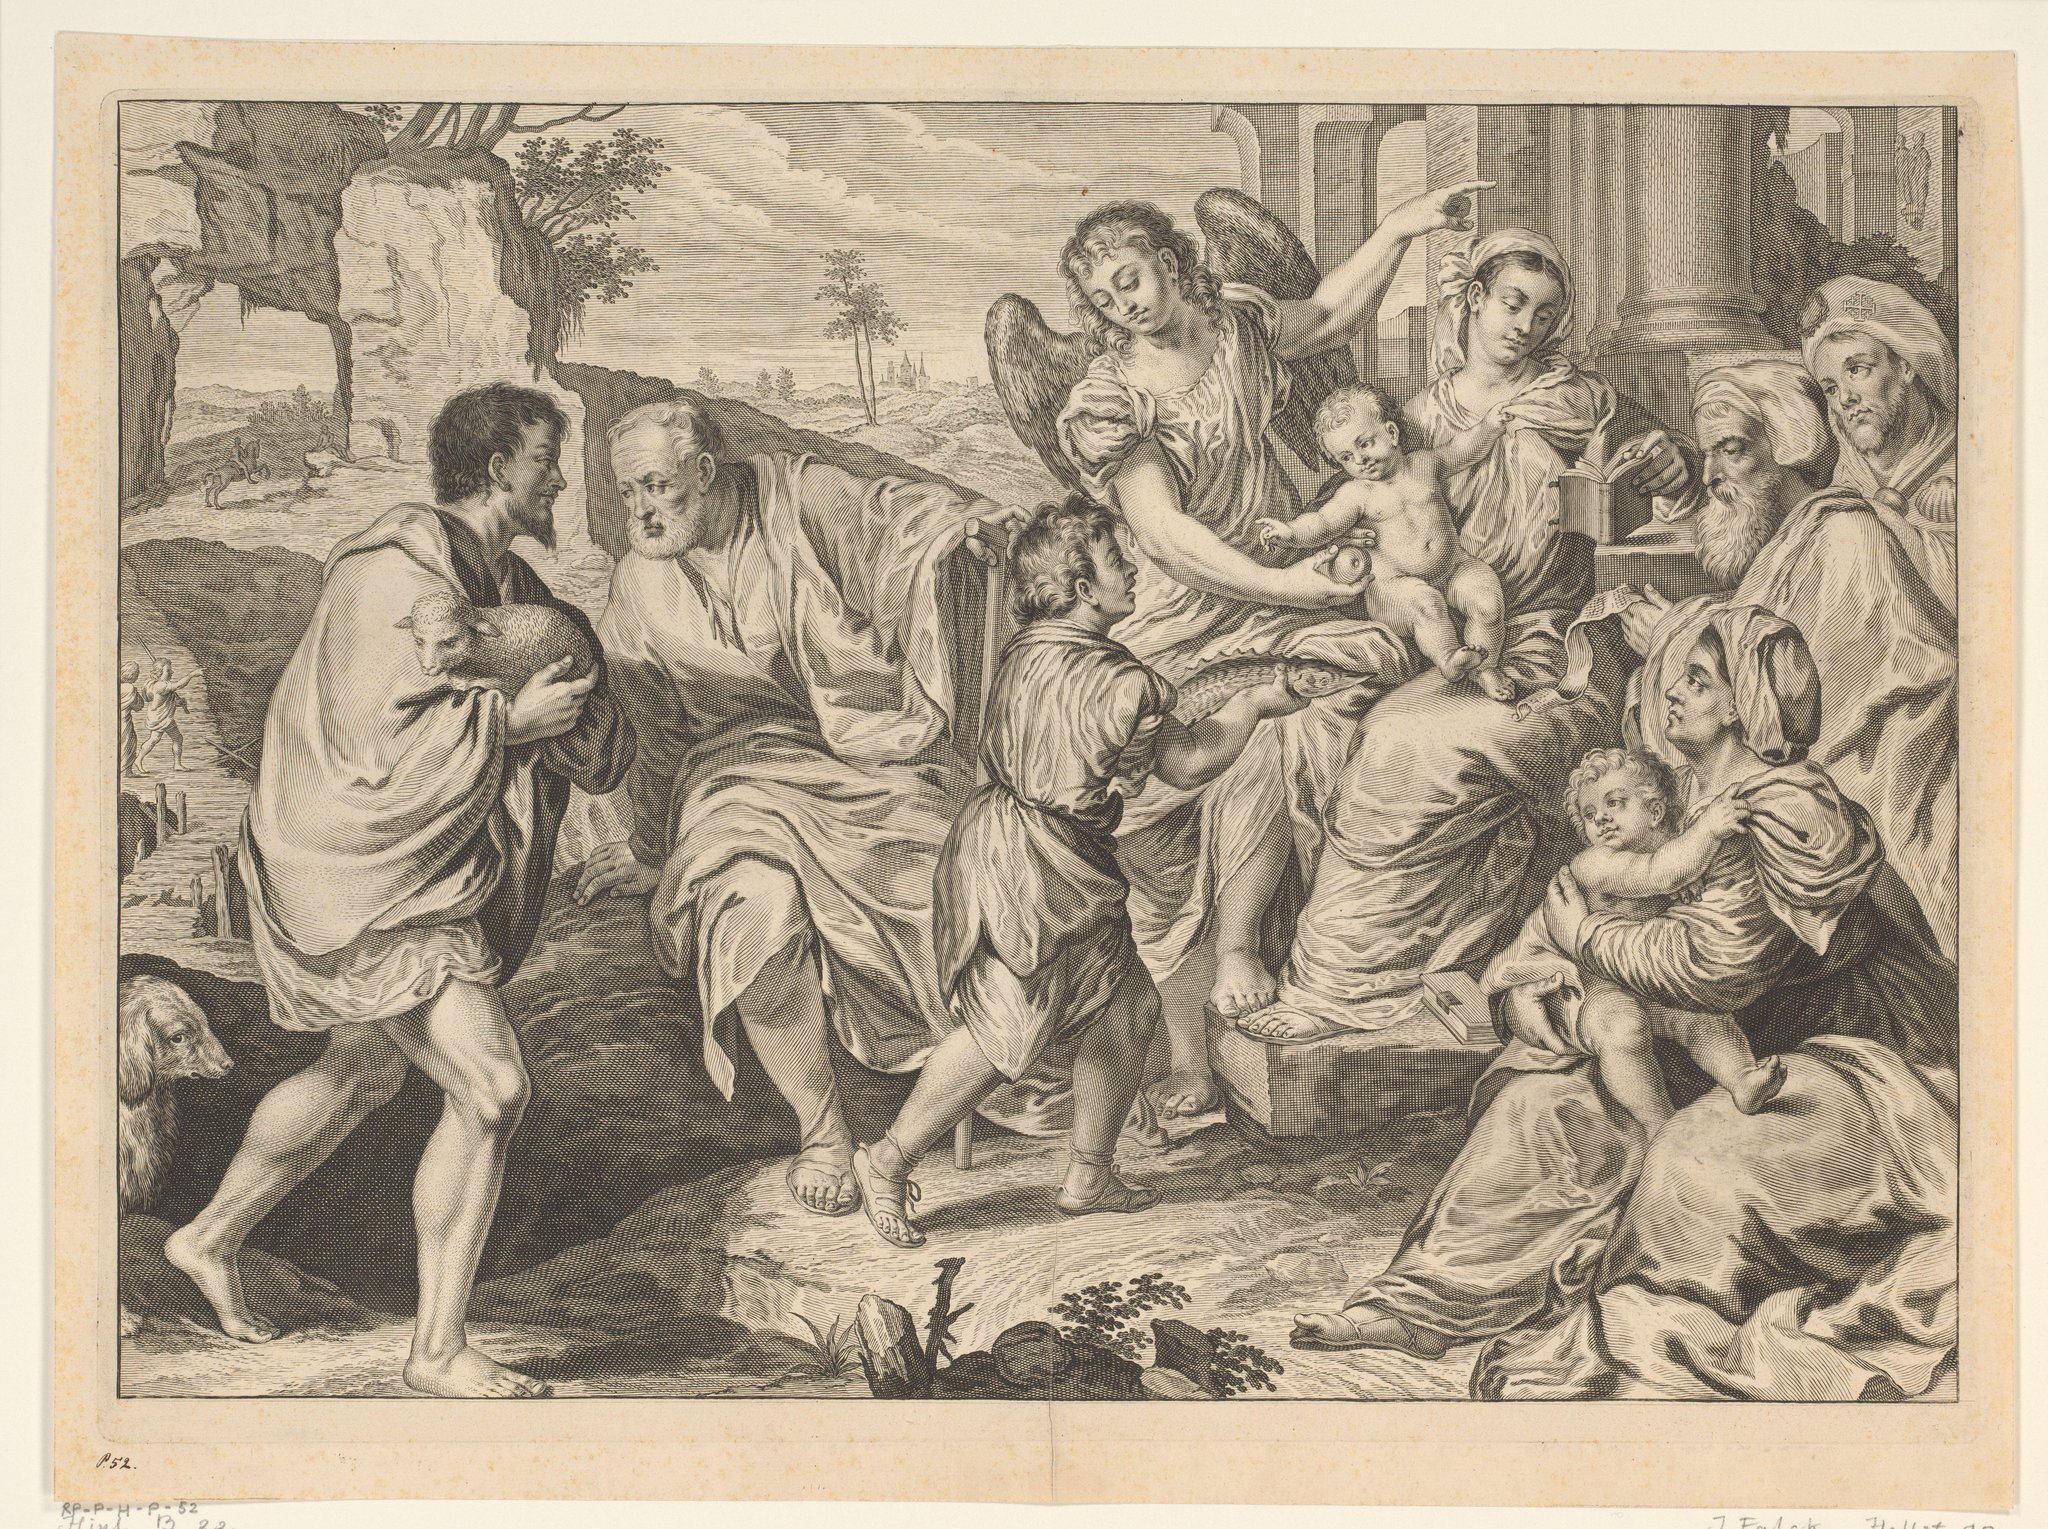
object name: print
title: Heilige familie in gezelschap van anderen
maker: jeremias falck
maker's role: print maker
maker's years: 1609-1677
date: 1646-1658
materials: paper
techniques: engraving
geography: amsterdam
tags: holy family with john the baptist (as child)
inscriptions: collector's mark: Lugt 11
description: Deze prent maakte ten minste tot 1979 deel uit van een prentalbum met de titel: 't Cabinet der Italiaense schilderije antique statue en borstbeelde van de heer Renst 145 stucks. Simon Schijnvoet heeft in 1709 aan dit album het Schijnvoet-nummer 22, liber nummer 20 toegekend. Prent uit serie Caelaturae met vierendertig reprodukties naar Italiaanse en Nederlandse schilders, vervaardigd door de allerbeste graveurs in opdracht van de verzamelaar Gerard Reynst.